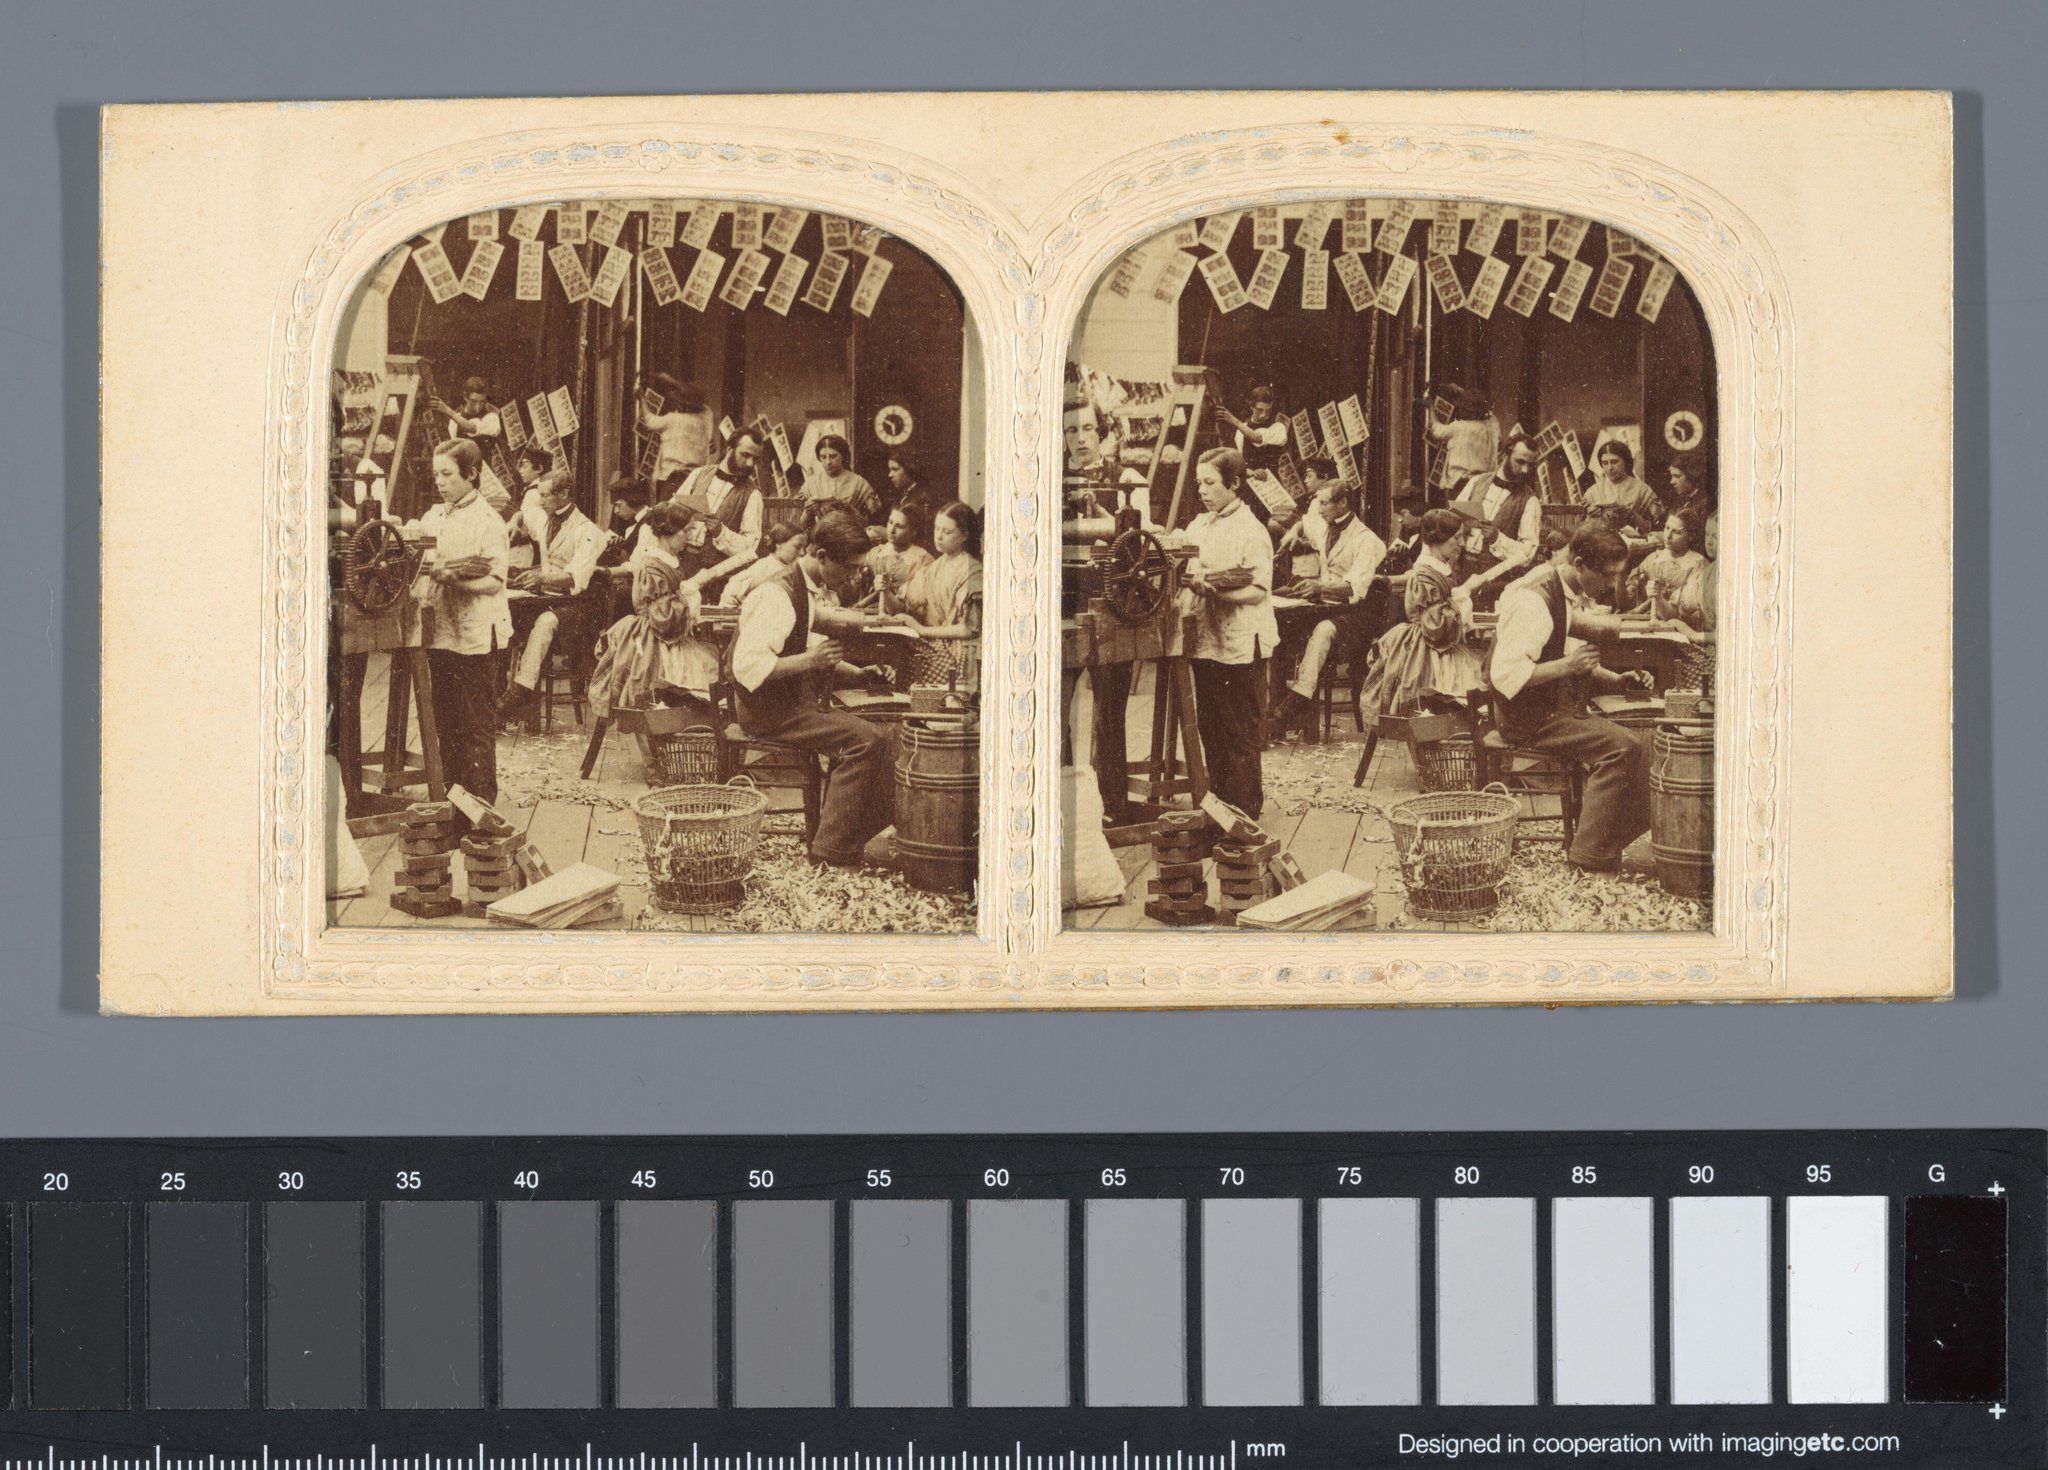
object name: stereograph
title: De stereofabriek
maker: alexis gaudin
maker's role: publisher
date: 1860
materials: photographic support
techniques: albumen print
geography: france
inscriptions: inscription: ‘onleesbaar’